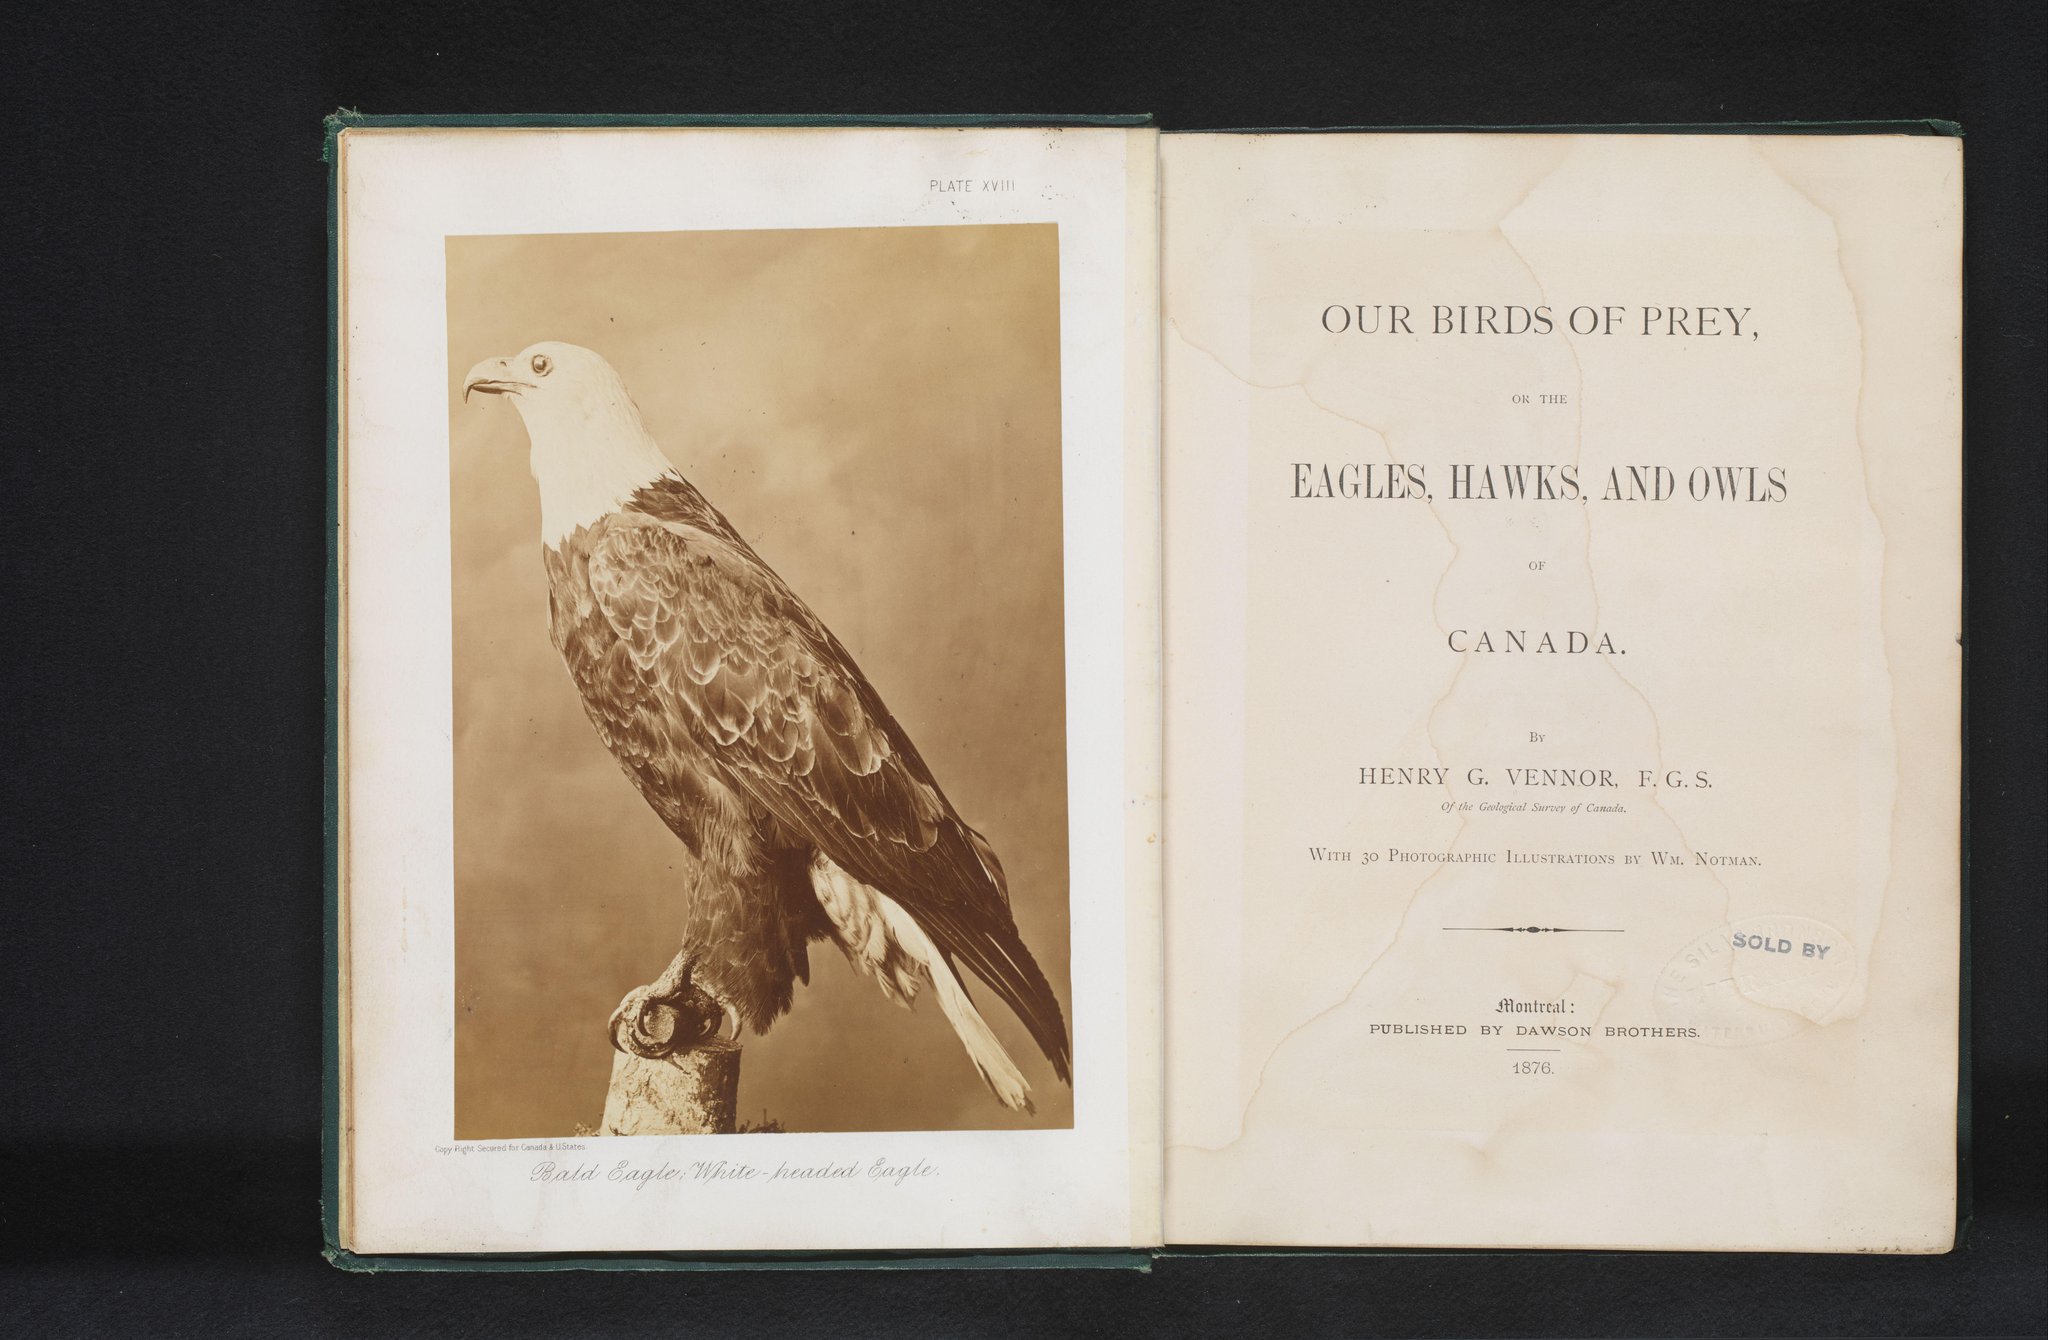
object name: photograph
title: Opgezette Amerikaanse zeearend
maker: william notman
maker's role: fotograaf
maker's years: 1826-1891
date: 1871-1876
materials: paper, photographic support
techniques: albumen print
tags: predatory birds: eagle, collection of animals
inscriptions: number: ‘PLATE XVIII’, inscription: ‘Copy Right Secured for Canada & U.States’